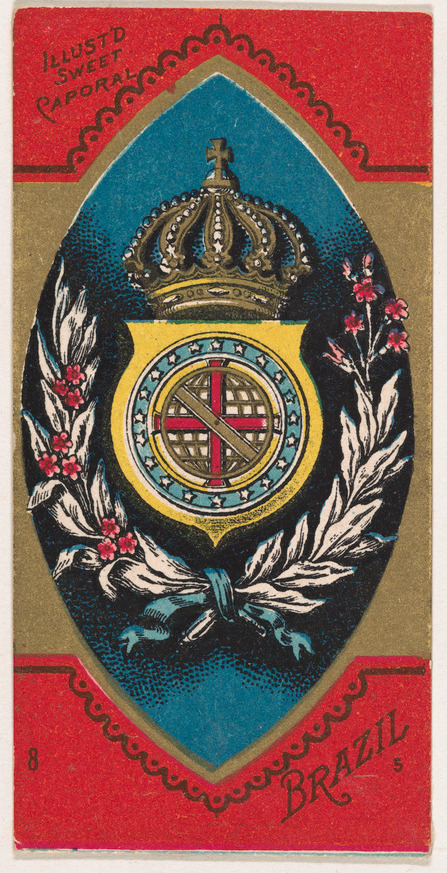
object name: print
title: Coat of Arms, Brazil, from the Military Series (N224) issued by Kinney Tobacco Company to promote Sweet Caporal Cigarettes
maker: kinney brothers tobacco company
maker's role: publisher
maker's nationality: american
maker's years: 1869-2011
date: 1888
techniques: color lithograph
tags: military,coat of arms